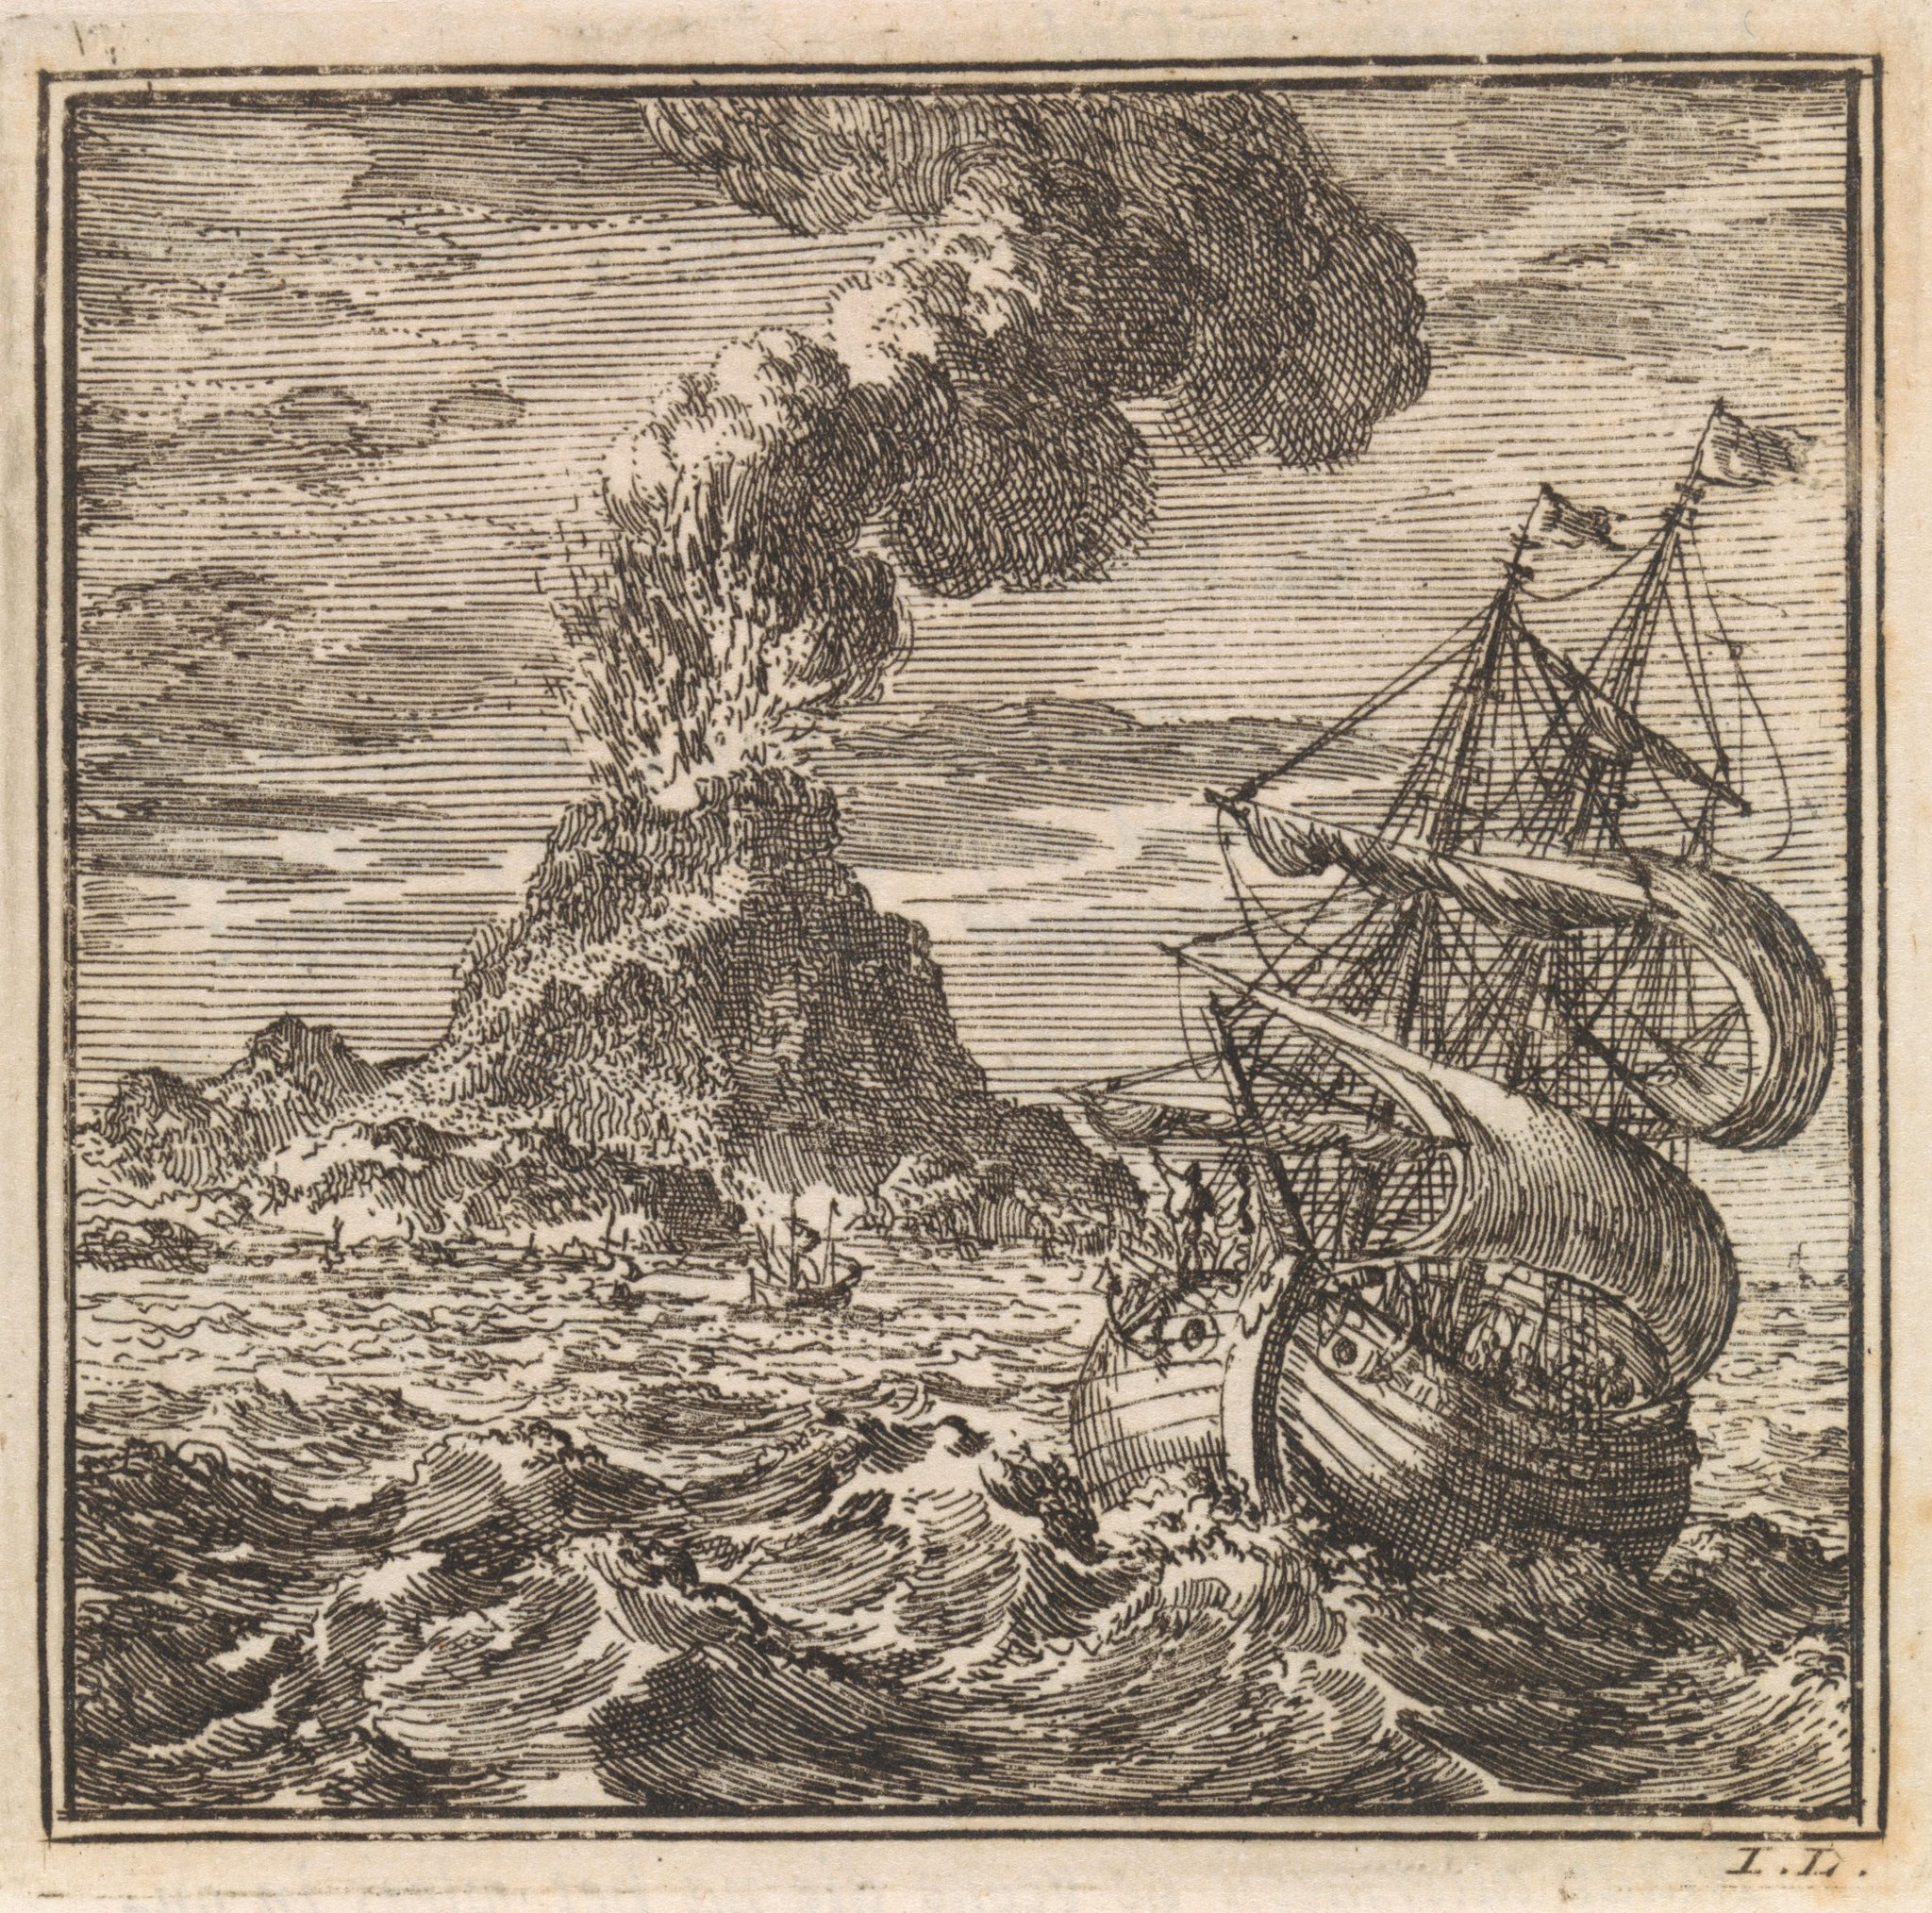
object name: book illustration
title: Gezicht vanaf de zee op de vulkaan Hekla die uitbarst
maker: jan luyken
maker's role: draughtsman, print maker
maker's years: 1649-1712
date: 1711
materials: paper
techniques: etching, letterpress printing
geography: amsterdam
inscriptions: collector's mark: Lugt 2228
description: Illustratie voor: Luyken, Jan. De Bykorf des Gemoeds. Amsterdam: Pieter Arentsz. II (wed.) en Cornelis van der Sys, 1711, p. 222.